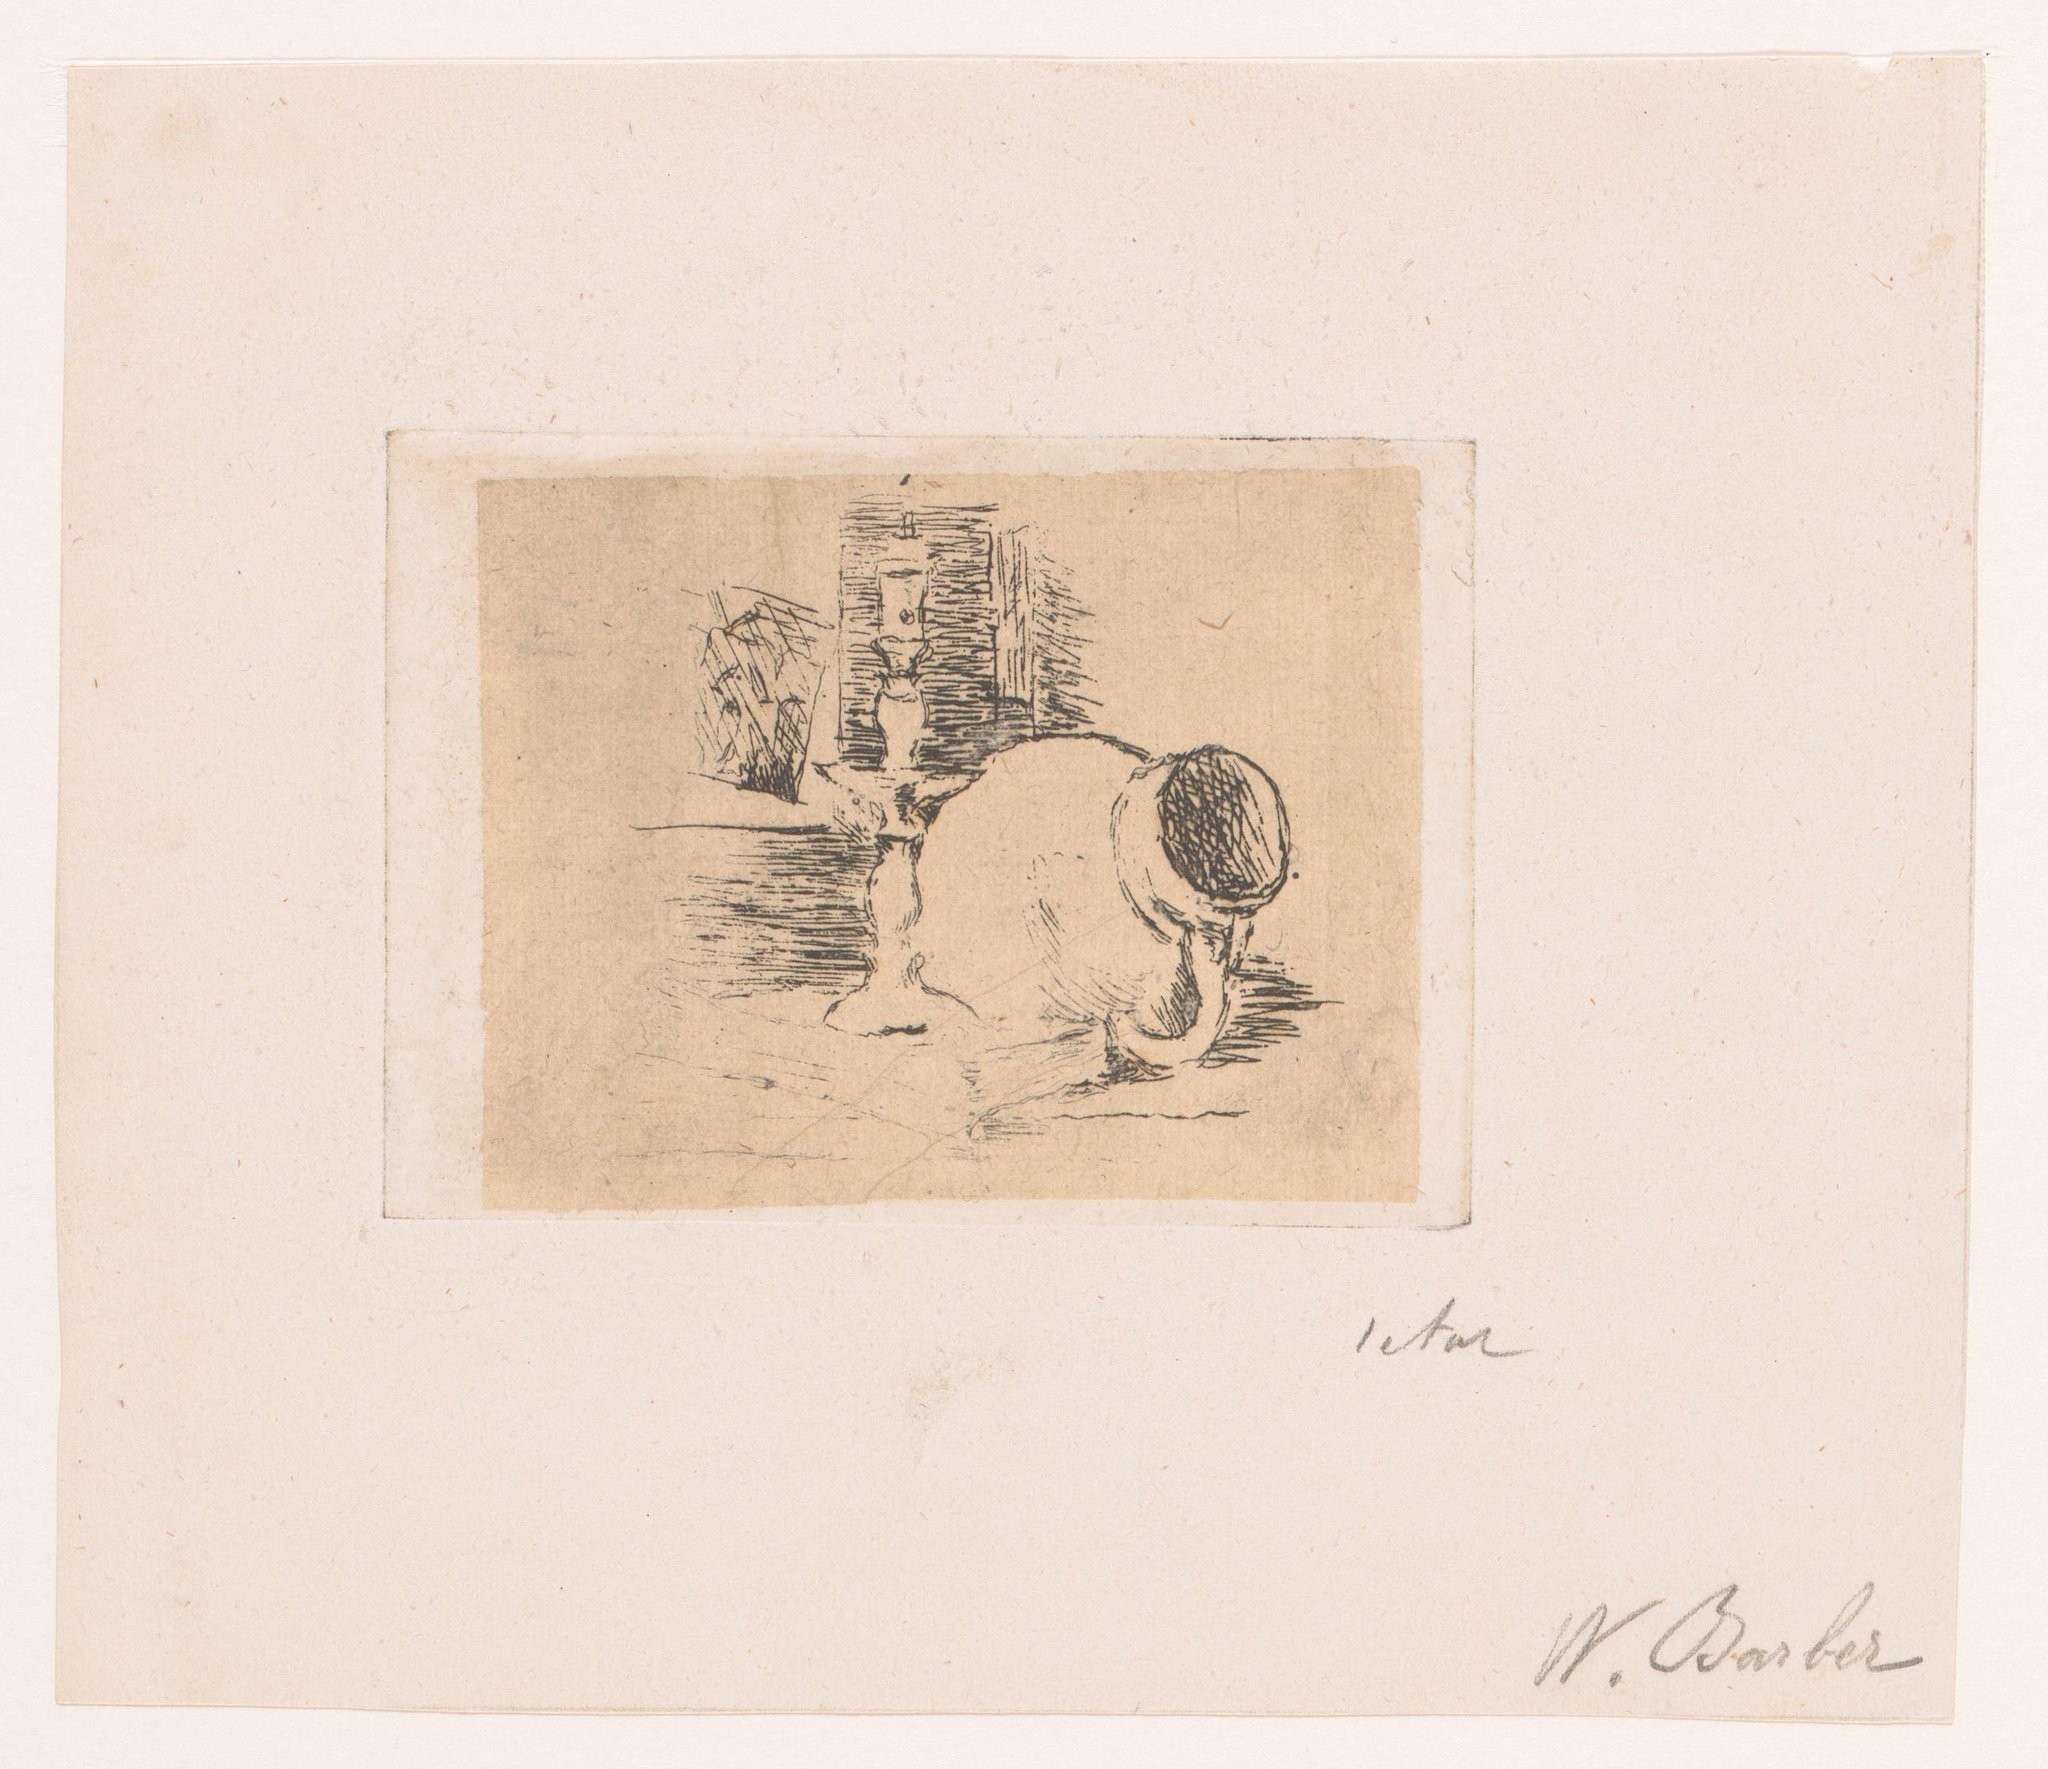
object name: print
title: Stilleven met kruik en een kandelaar op een boek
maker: w.f. barber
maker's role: print maker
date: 1850-1909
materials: paper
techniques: etching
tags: still life of miscellaneous objects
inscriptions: collector's mark: Lugt 2228, annotation: ‘1 etat’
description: Sterfdatum kunstenaar onbekend. Derhalve is voor bepaling van de rechten van dit object de verwervingsdatum aangehouden.